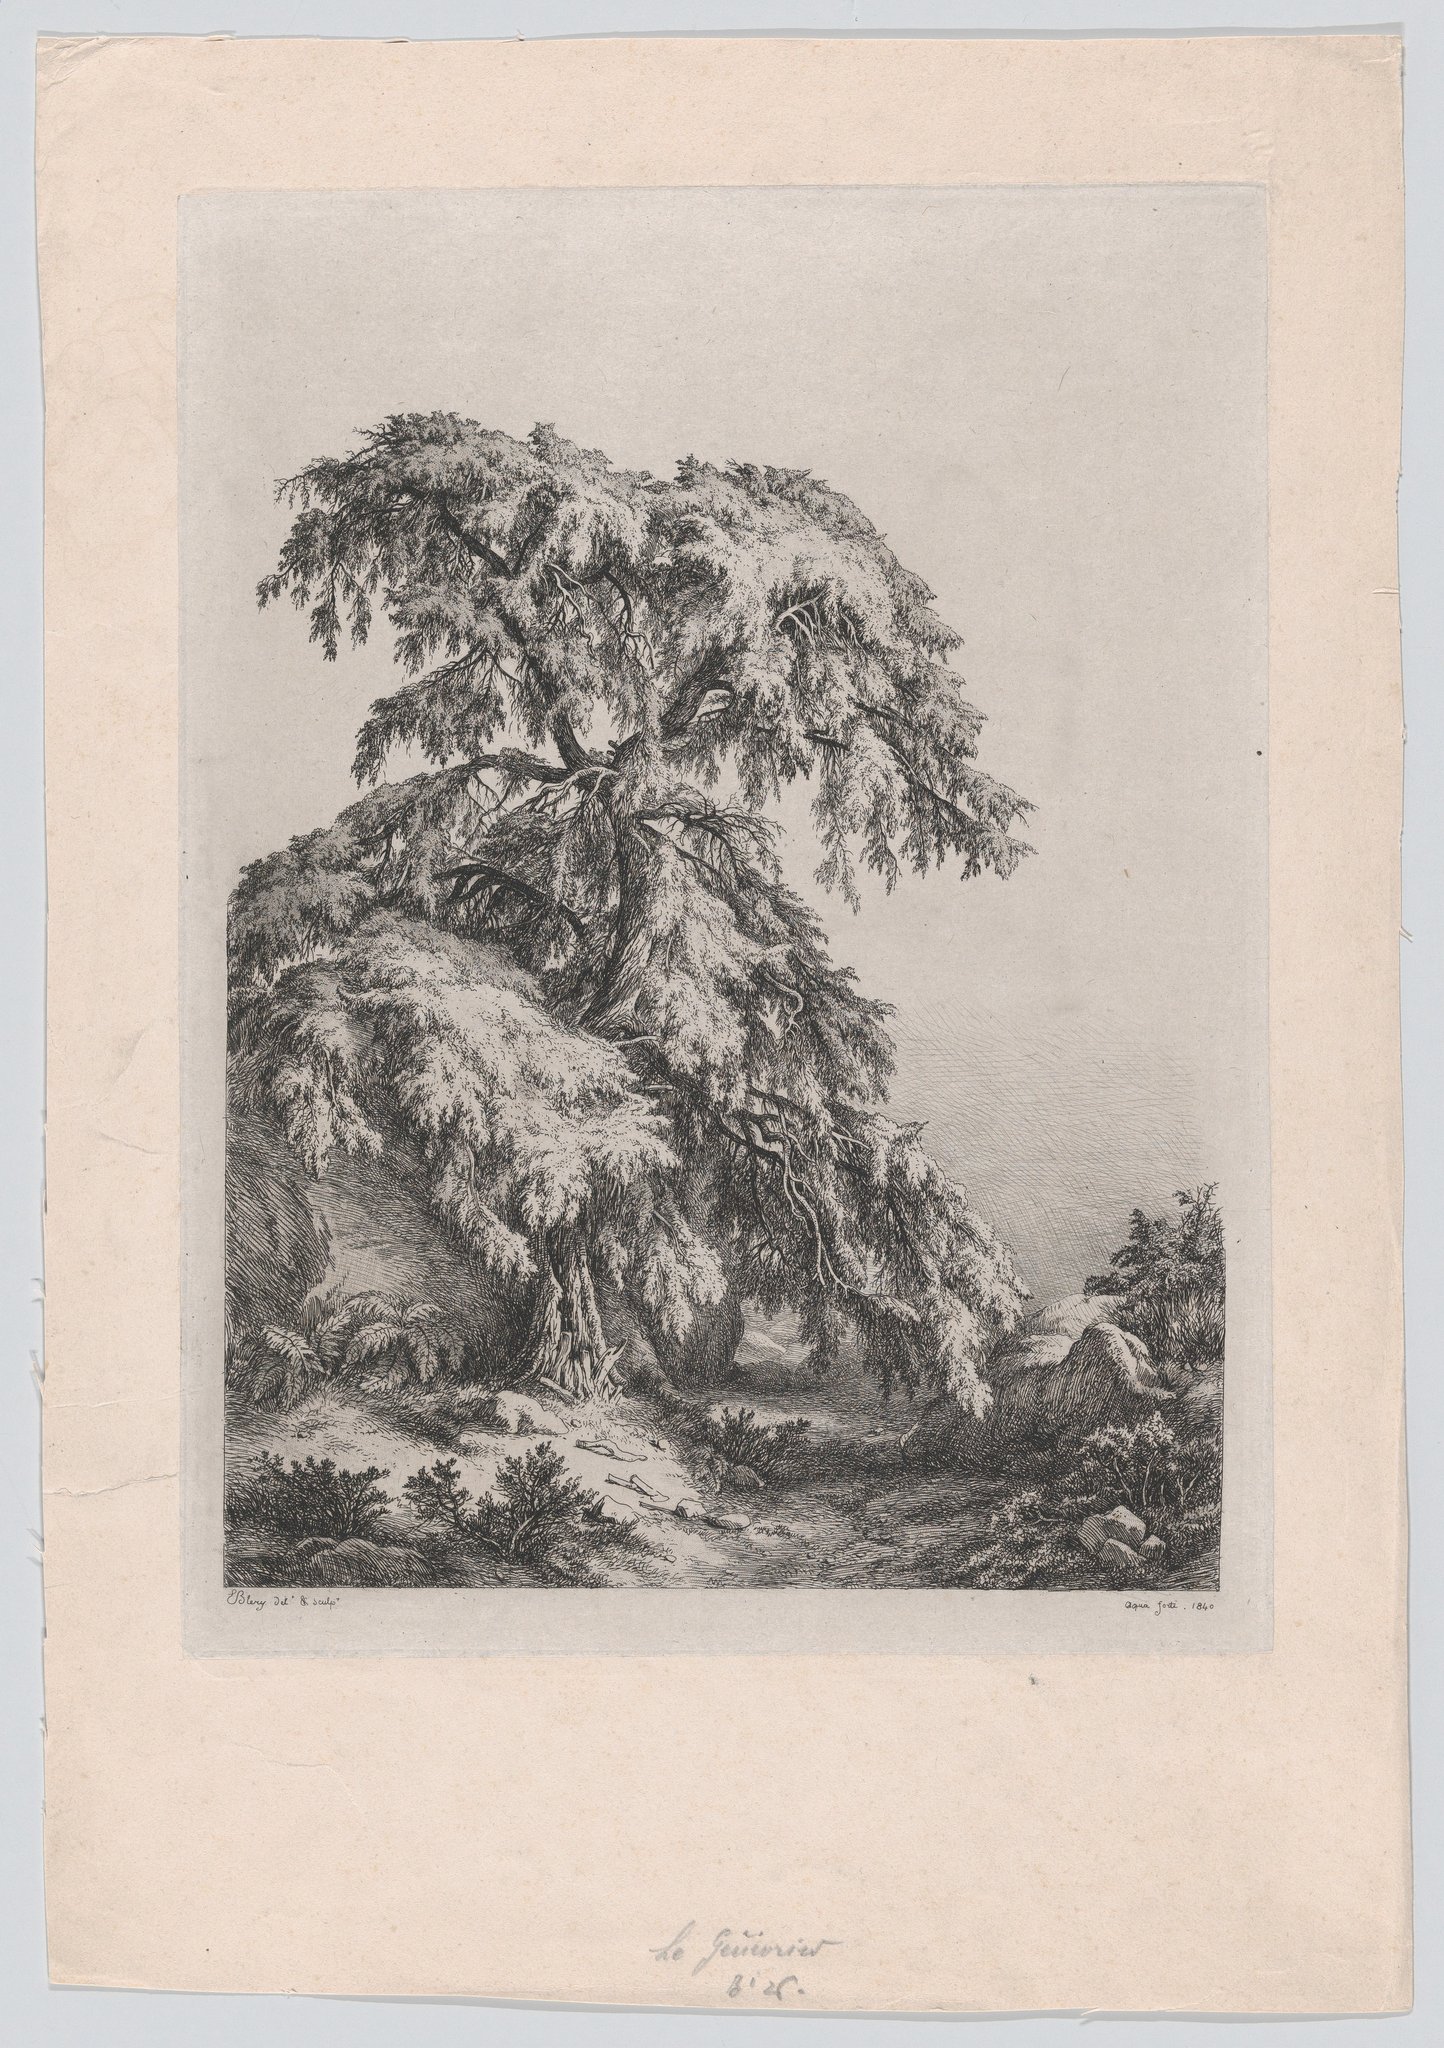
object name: print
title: The Juniper Tree, Fontainbleu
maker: eugène bléry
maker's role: artist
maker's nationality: french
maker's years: 1805-1887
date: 1840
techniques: etching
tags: trees